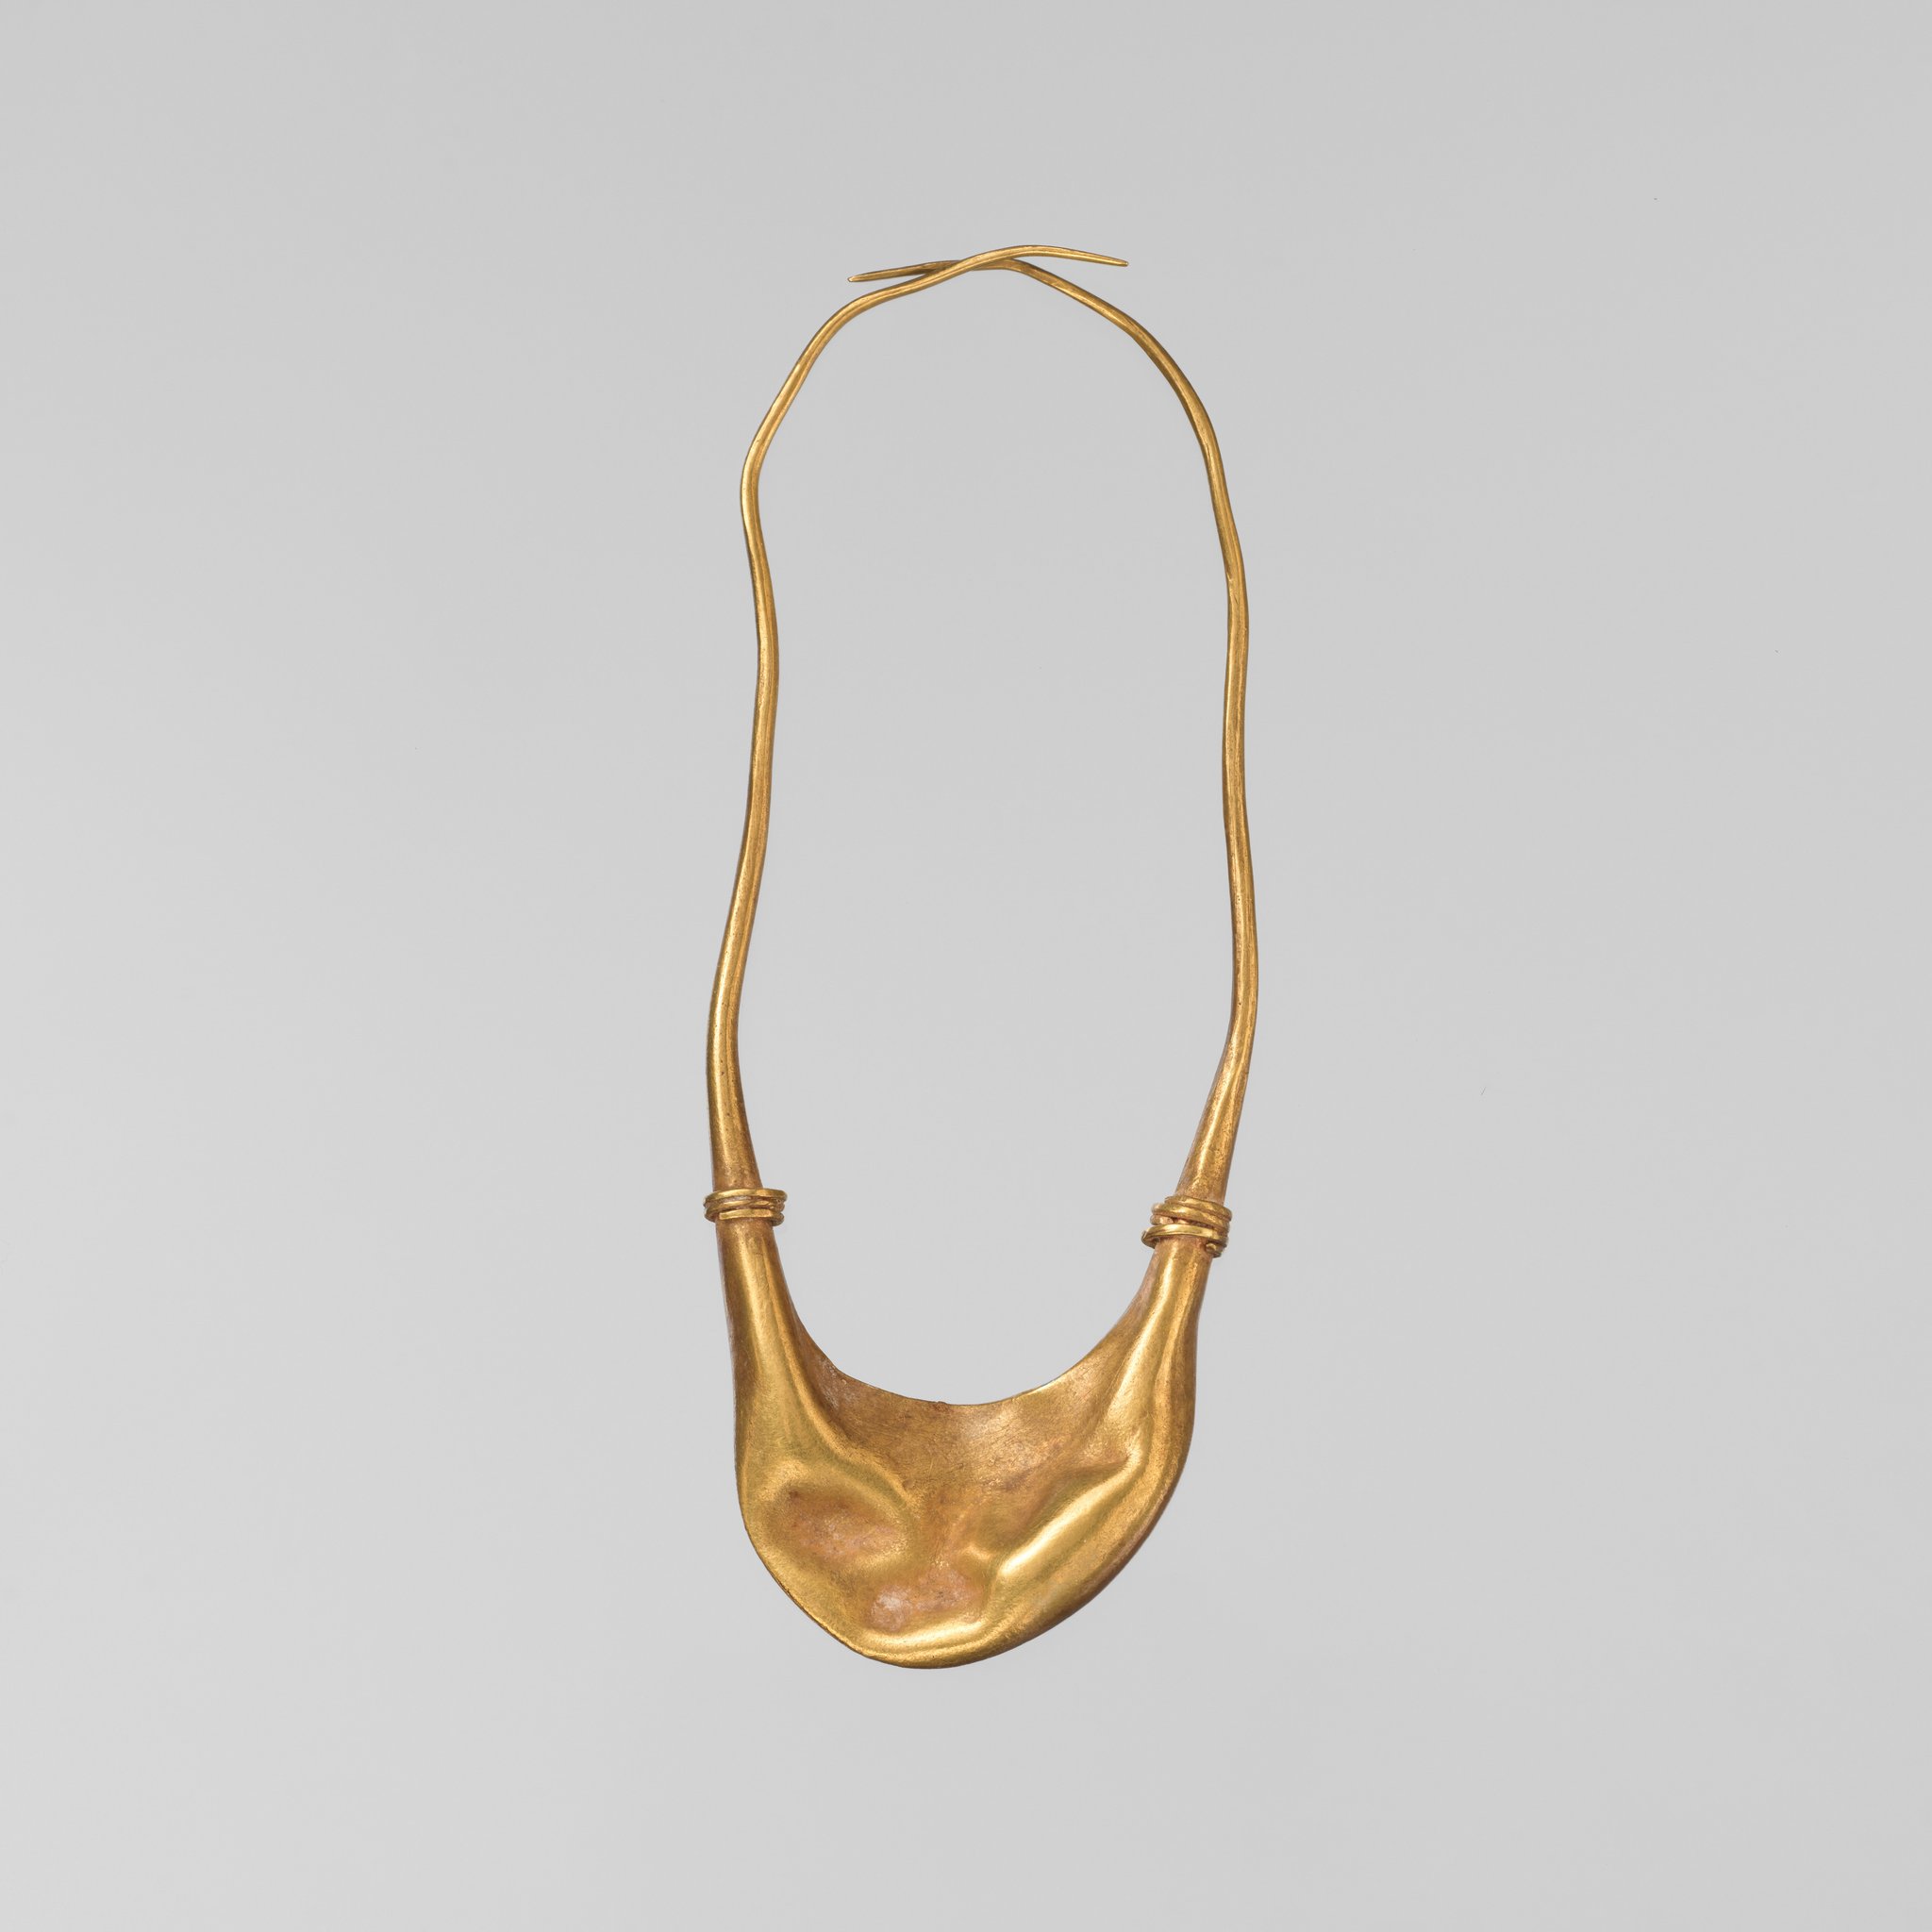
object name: earring, boat shaped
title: Gold boat-shaped earring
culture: cypriot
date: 1200-1050 BCE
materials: gold